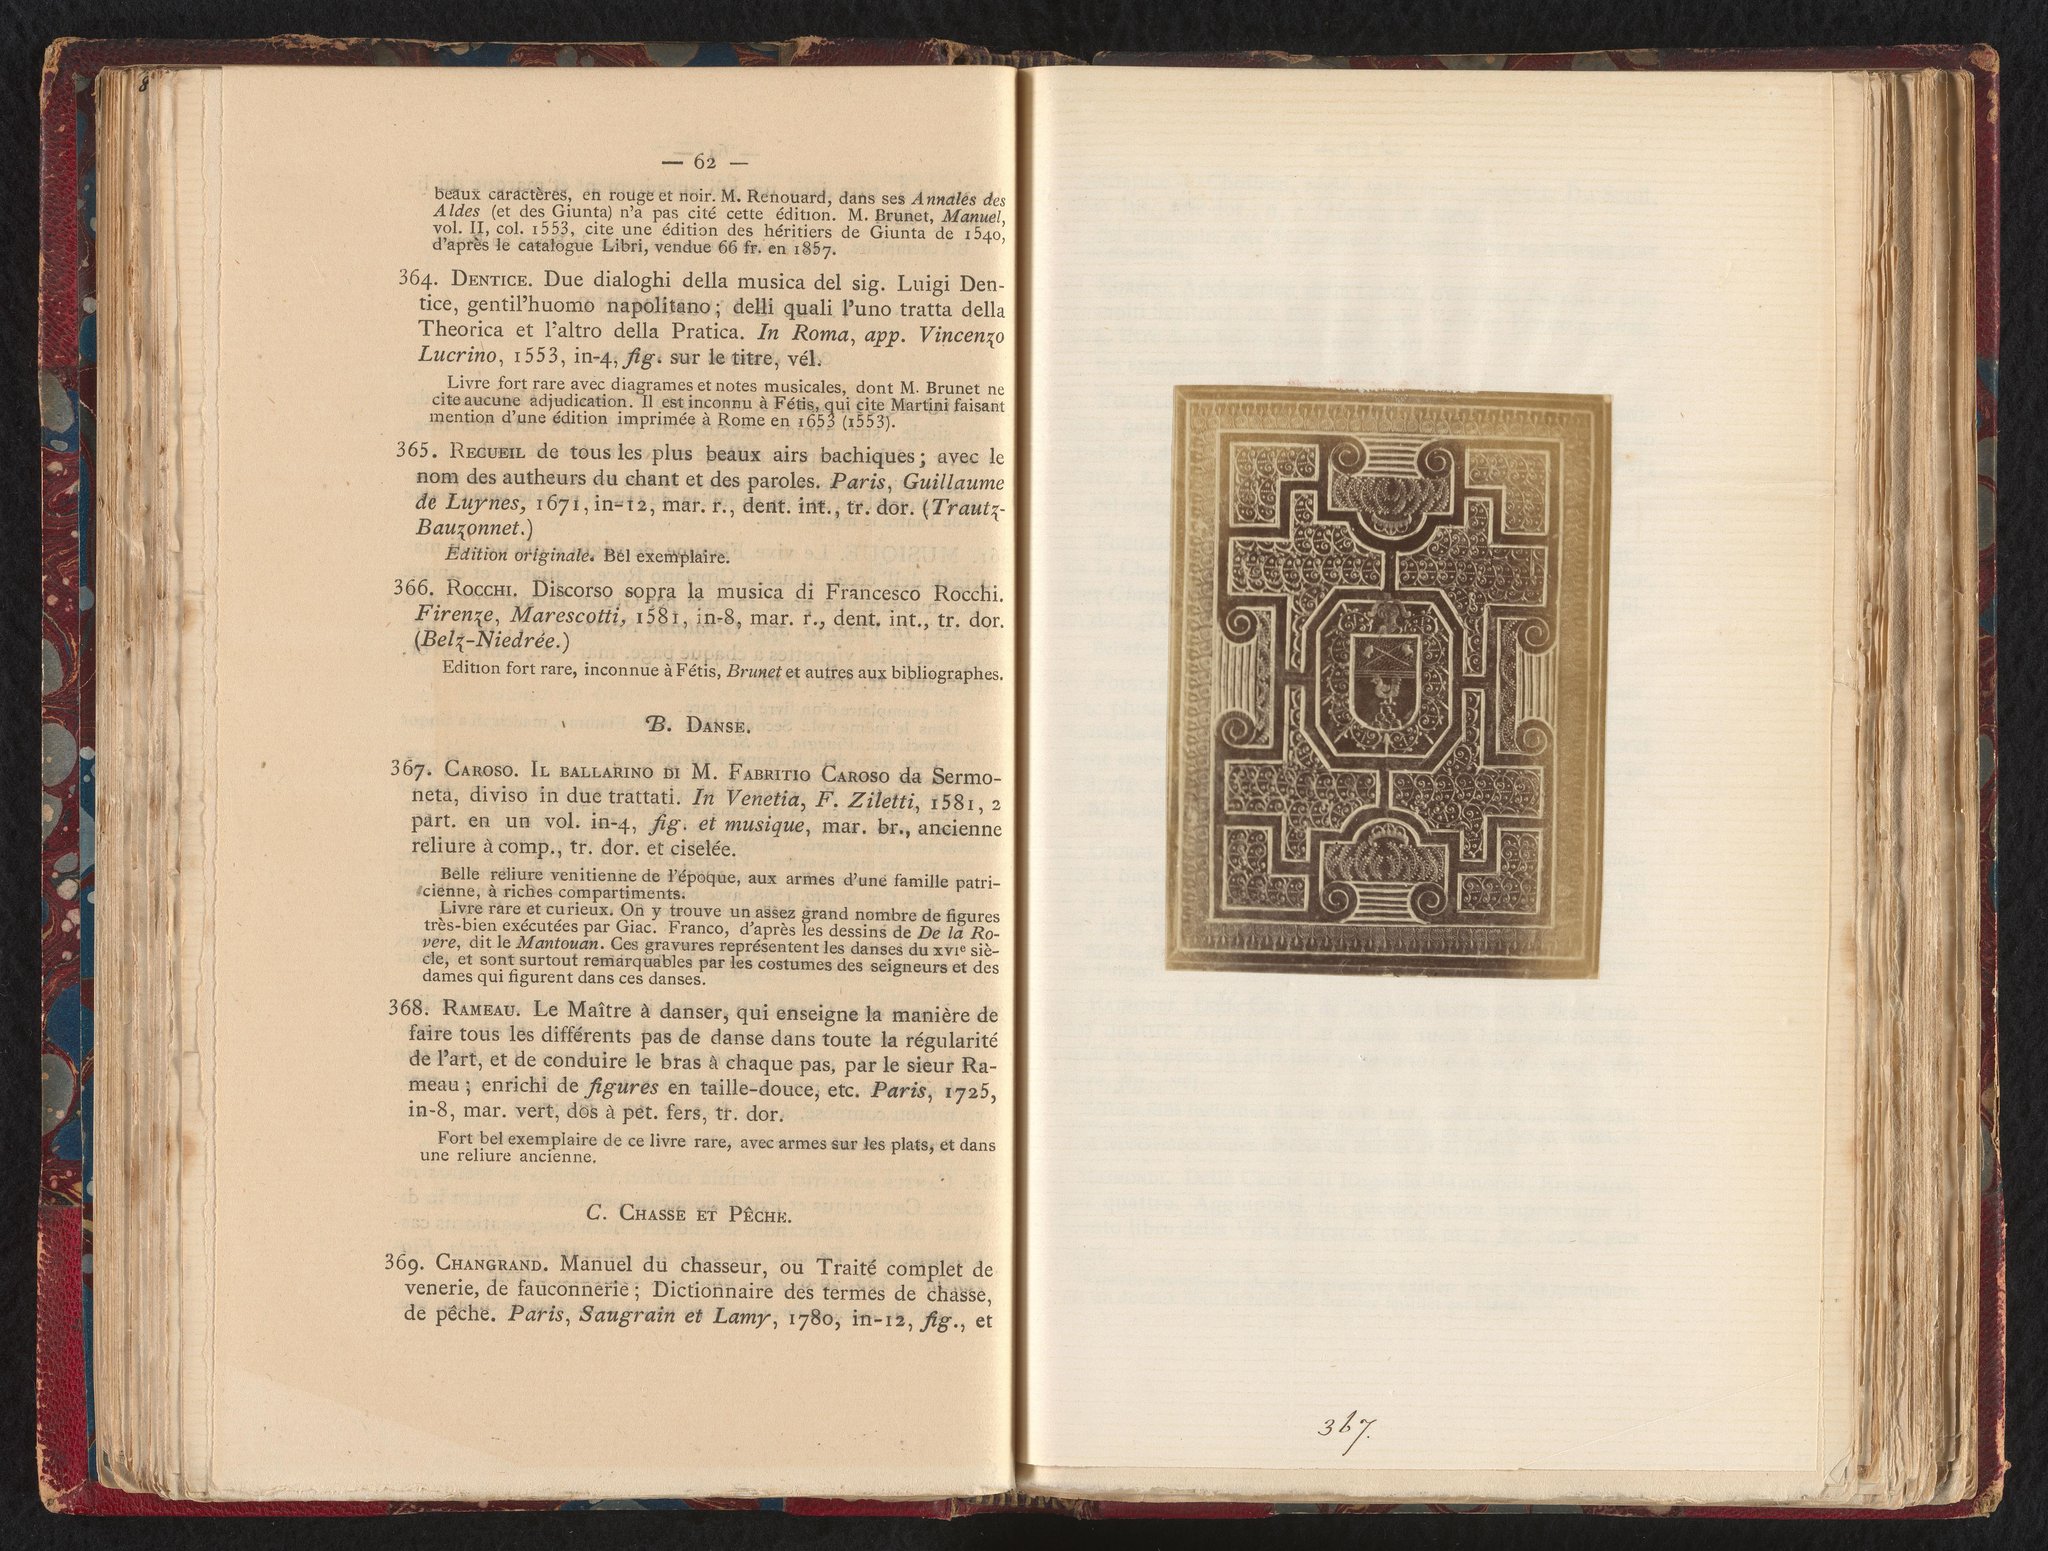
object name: reproduction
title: Fotoreproductie van boekomslag van Il Ballarino di M. Fabritio Caroso da Sermoneta (...) uit 1581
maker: Anonymous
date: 1863-1868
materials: paper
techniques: albumen print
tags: book-cover, binding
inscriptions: number: ‘367’